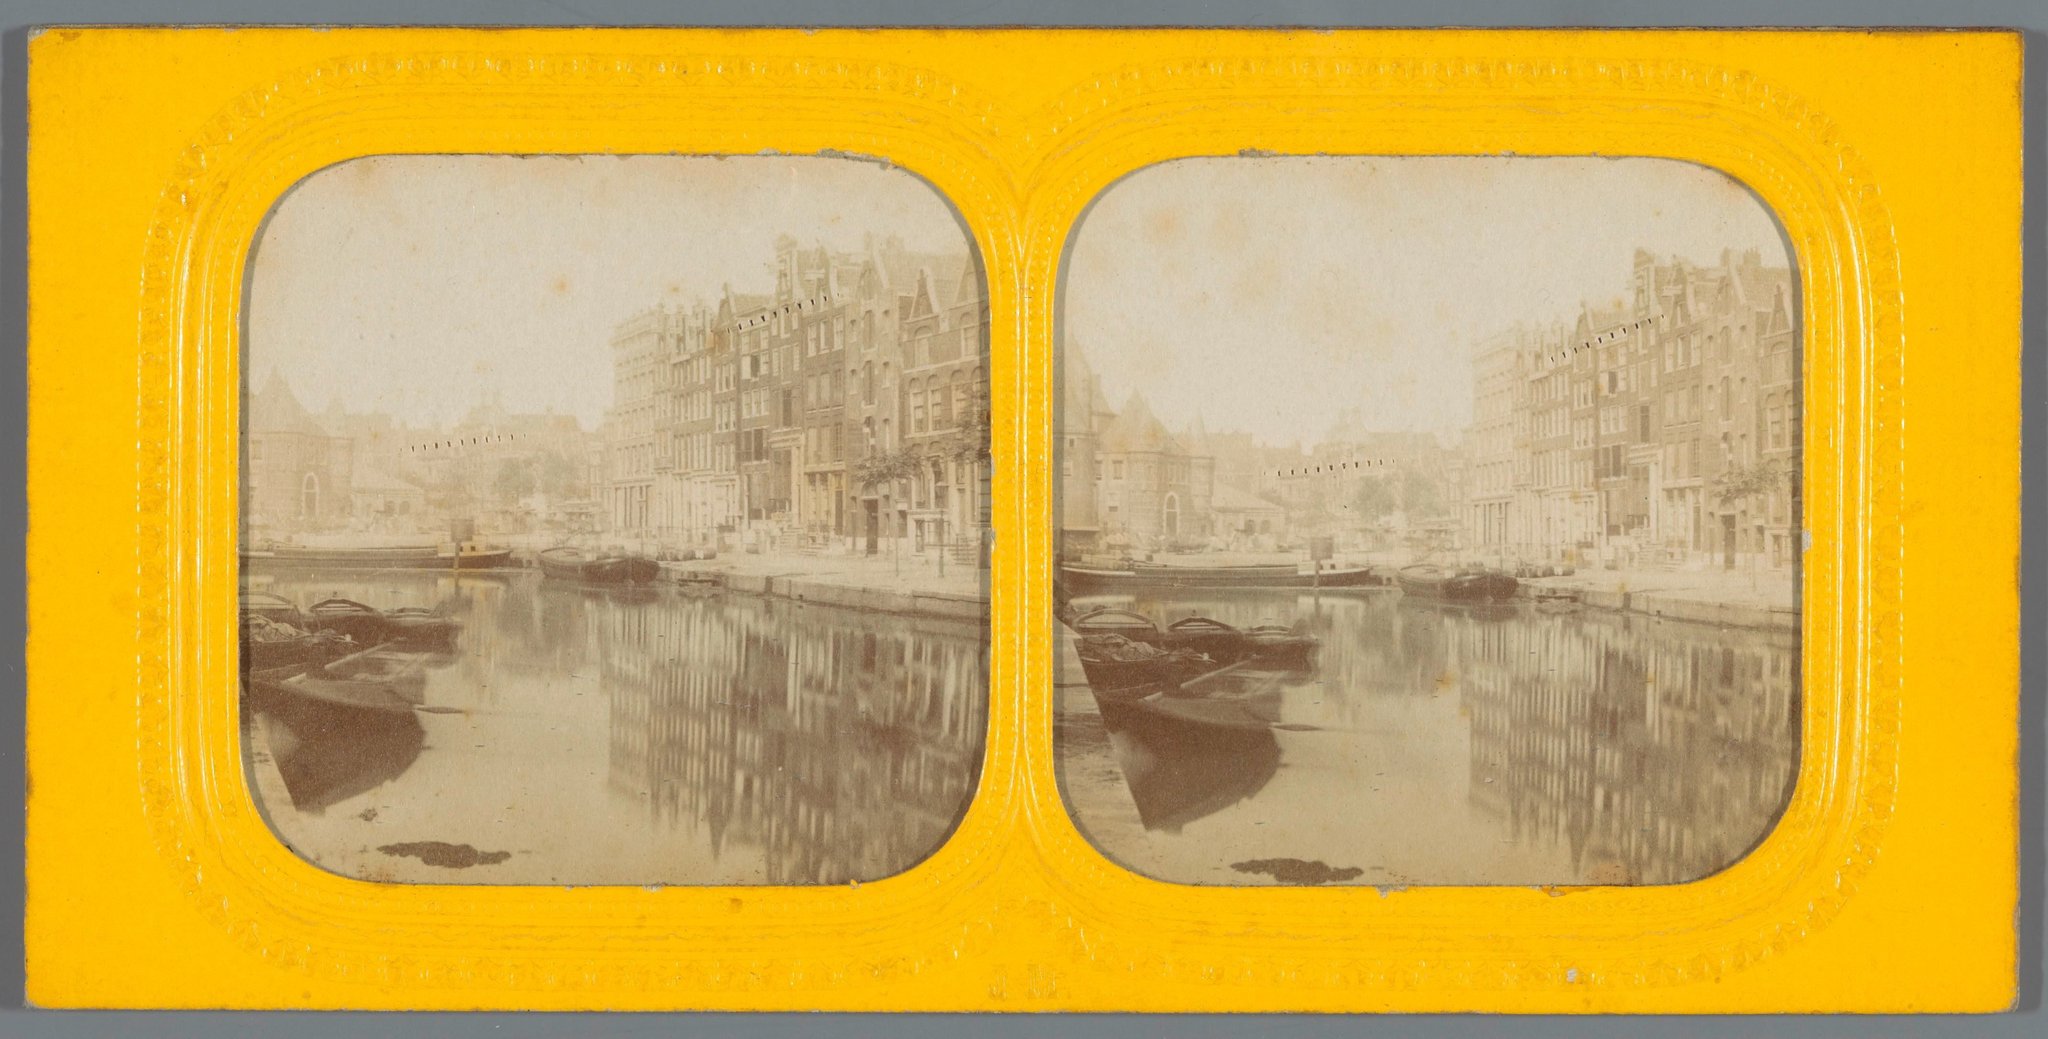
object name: tissue stereograph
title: Gezicht op een gracht in Amsterdam met links vermoedelijk de Waag op de Nieuwmarkt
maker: jules marinier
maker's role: publisher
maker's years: 1823-1896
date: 1860-1875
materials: cardboard, paper, photographic support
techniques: albumen print, cutting, hand coloring, perforating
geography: amsterdam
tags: canals, waters (in city), weigh-house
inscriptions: name: ‘Amsterdam, Poisonnerie’, name: ‘H. Wei[...]’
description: Gezicht op de Kloveniersburgwal te Amsterdam, met op de achtergrond De Waag.